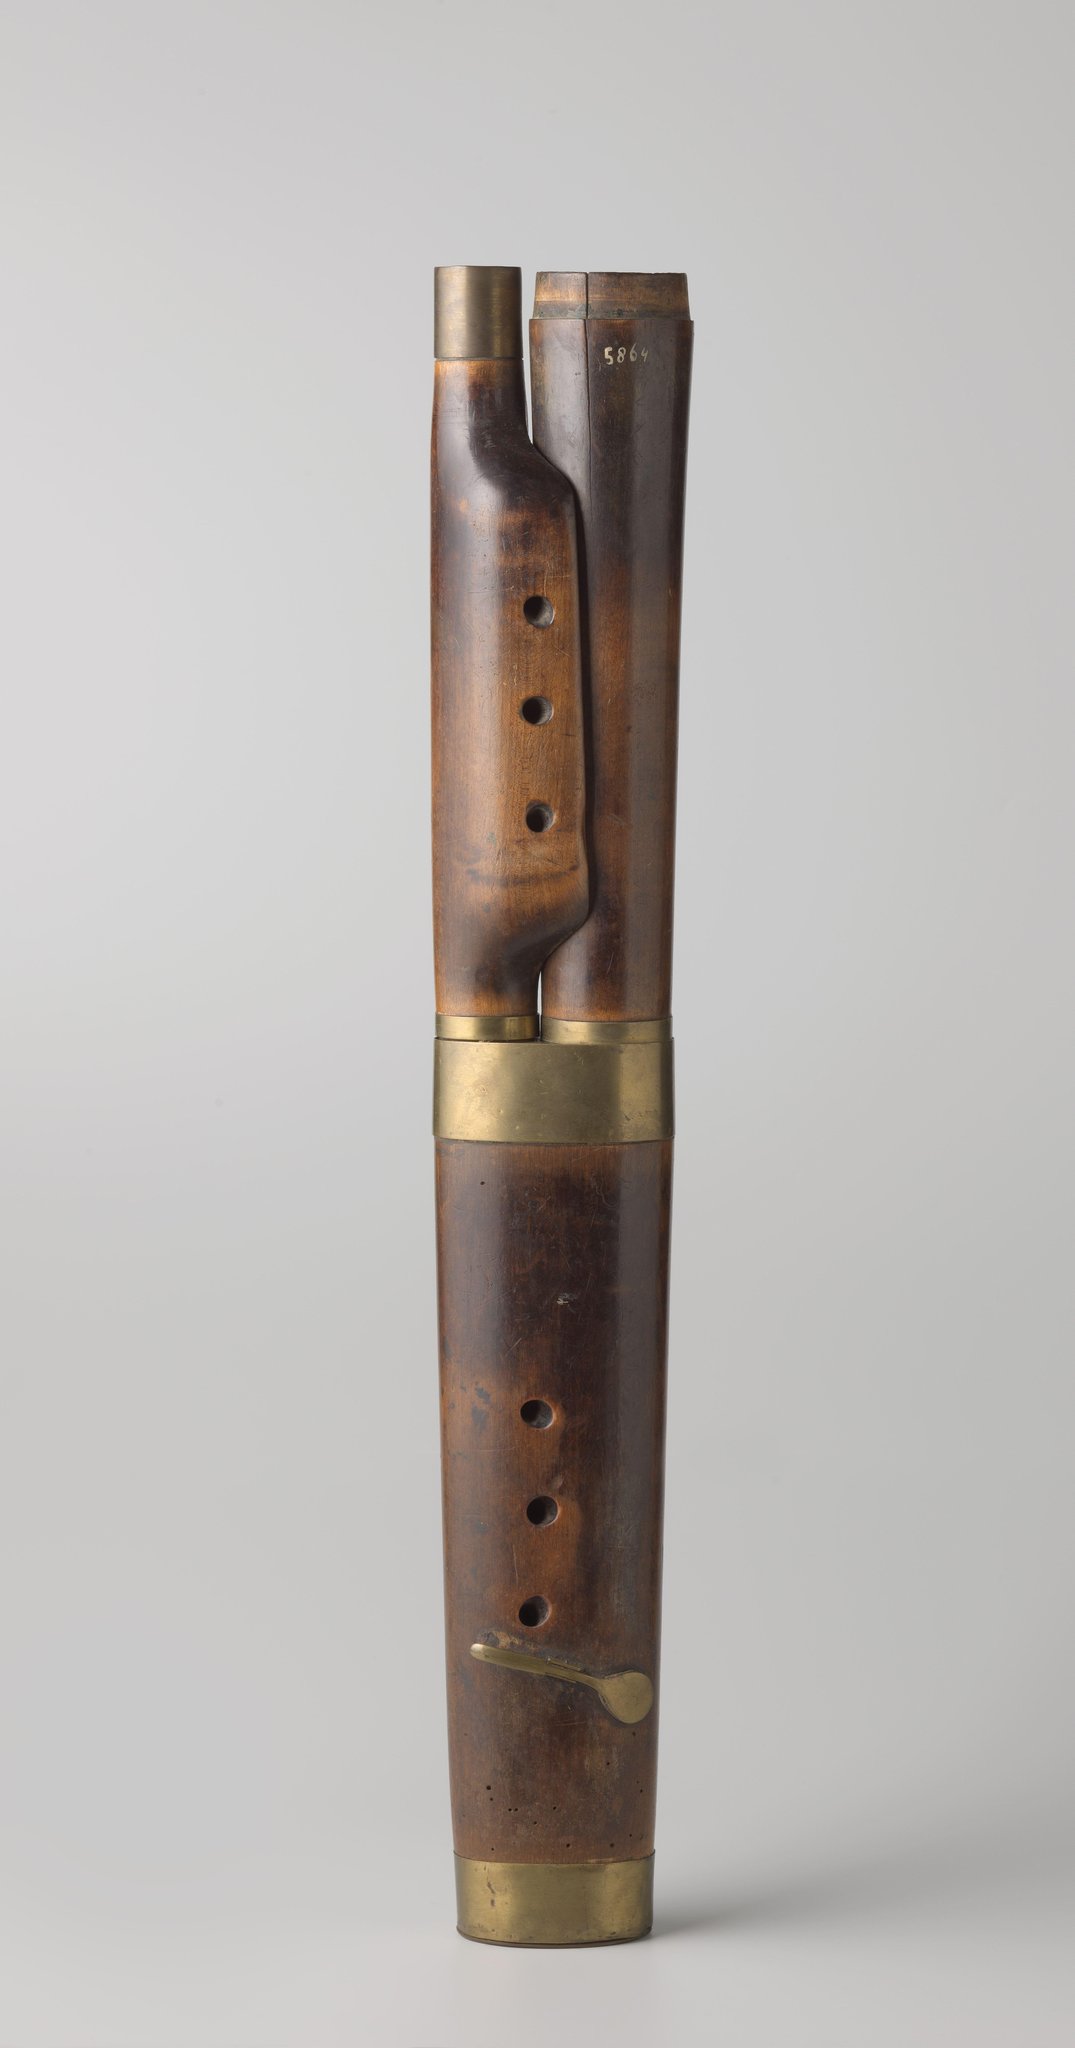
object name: russian bassoon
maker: stengel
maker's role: publisher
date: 1830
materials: copper, wood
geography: bayreuth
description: Russische fagot met koperen beslag en mondstukken en kleppen. De beker is verloren.